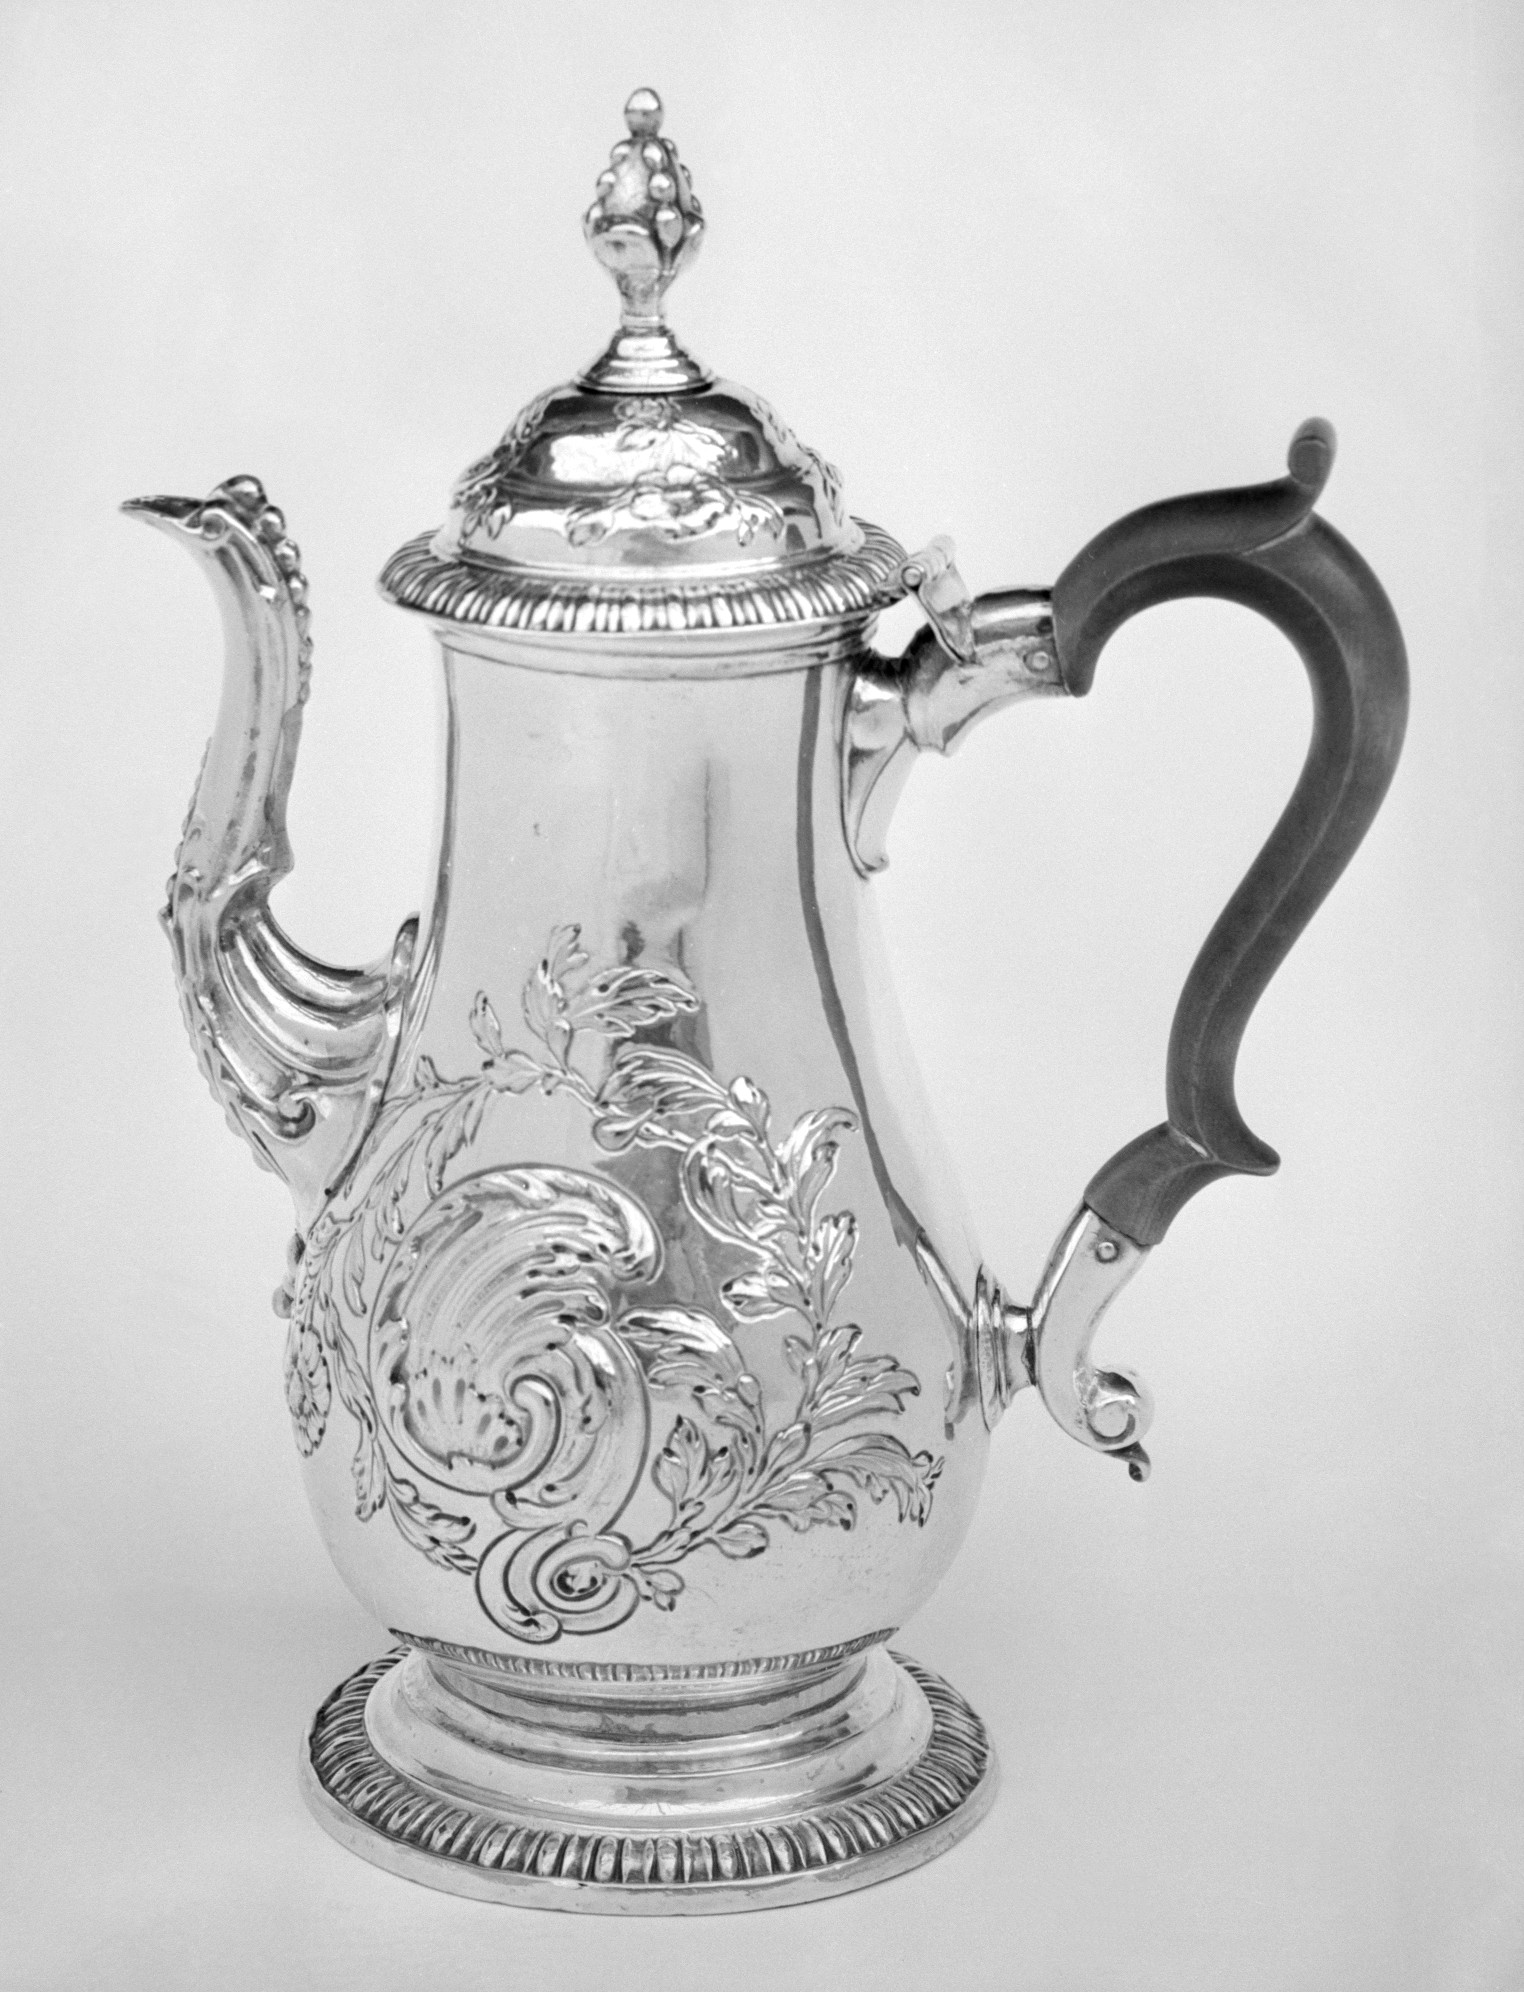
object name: coffeepot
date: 1765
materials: metal, wood